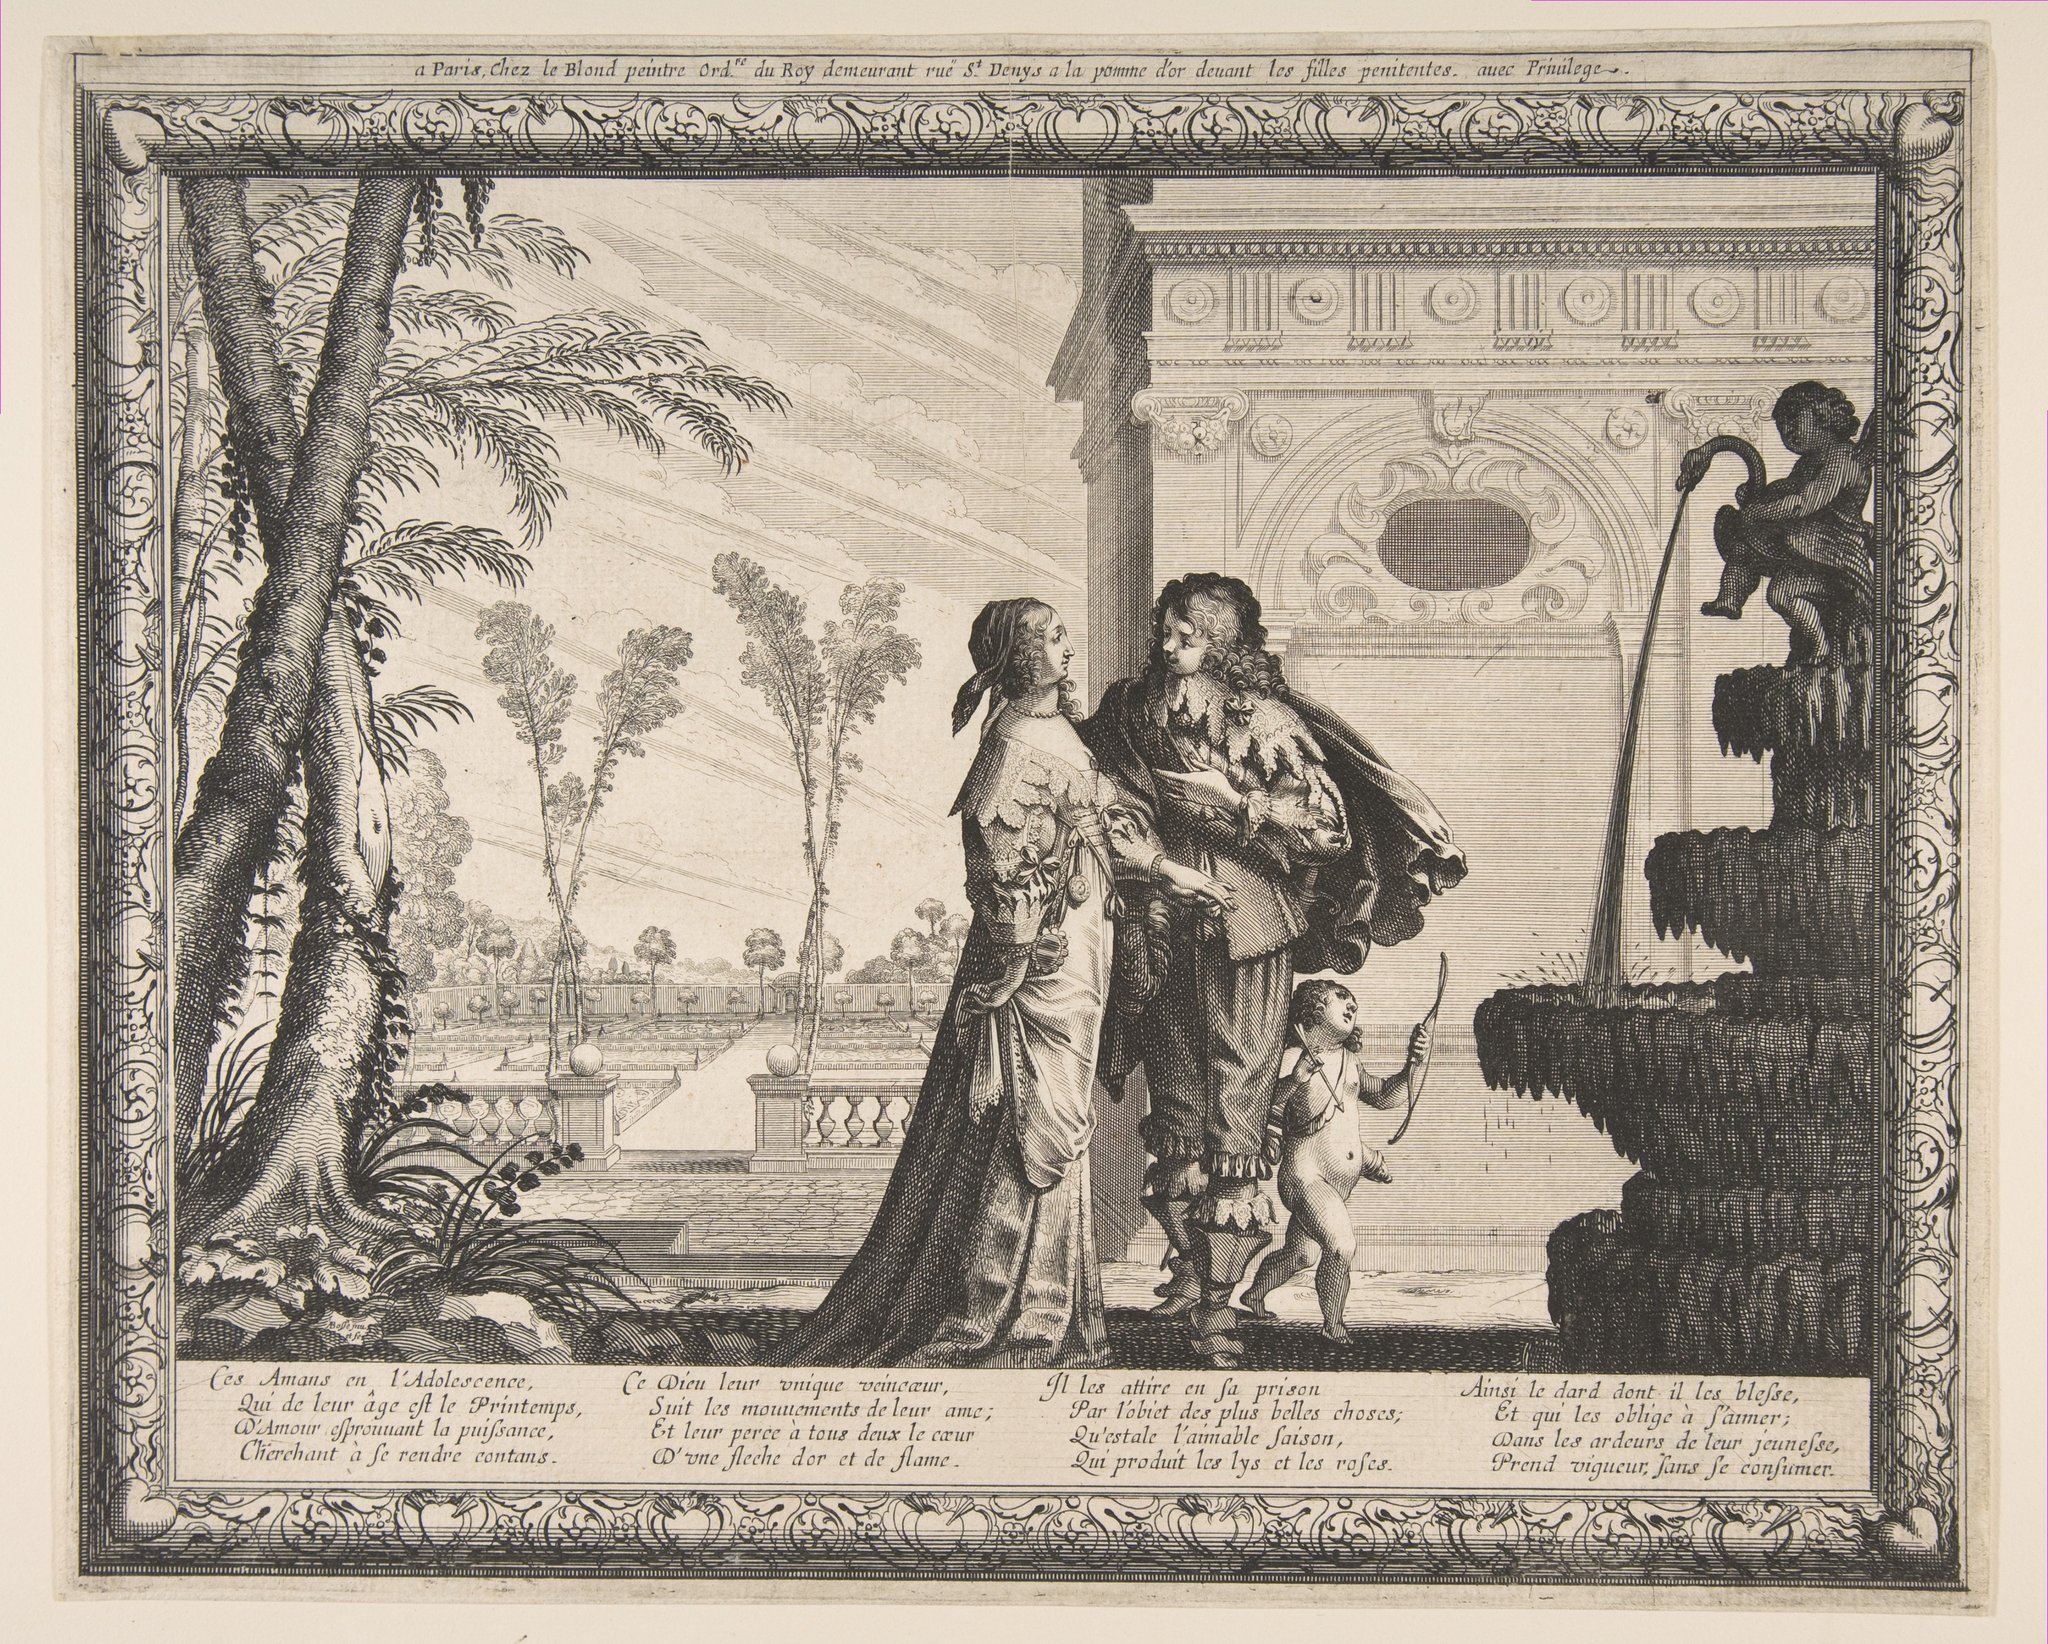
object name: print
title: Youth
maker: abraham bosse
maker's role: artist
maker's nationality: french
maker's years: 1602-1676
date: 1636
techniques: etching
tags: men,women,cupid